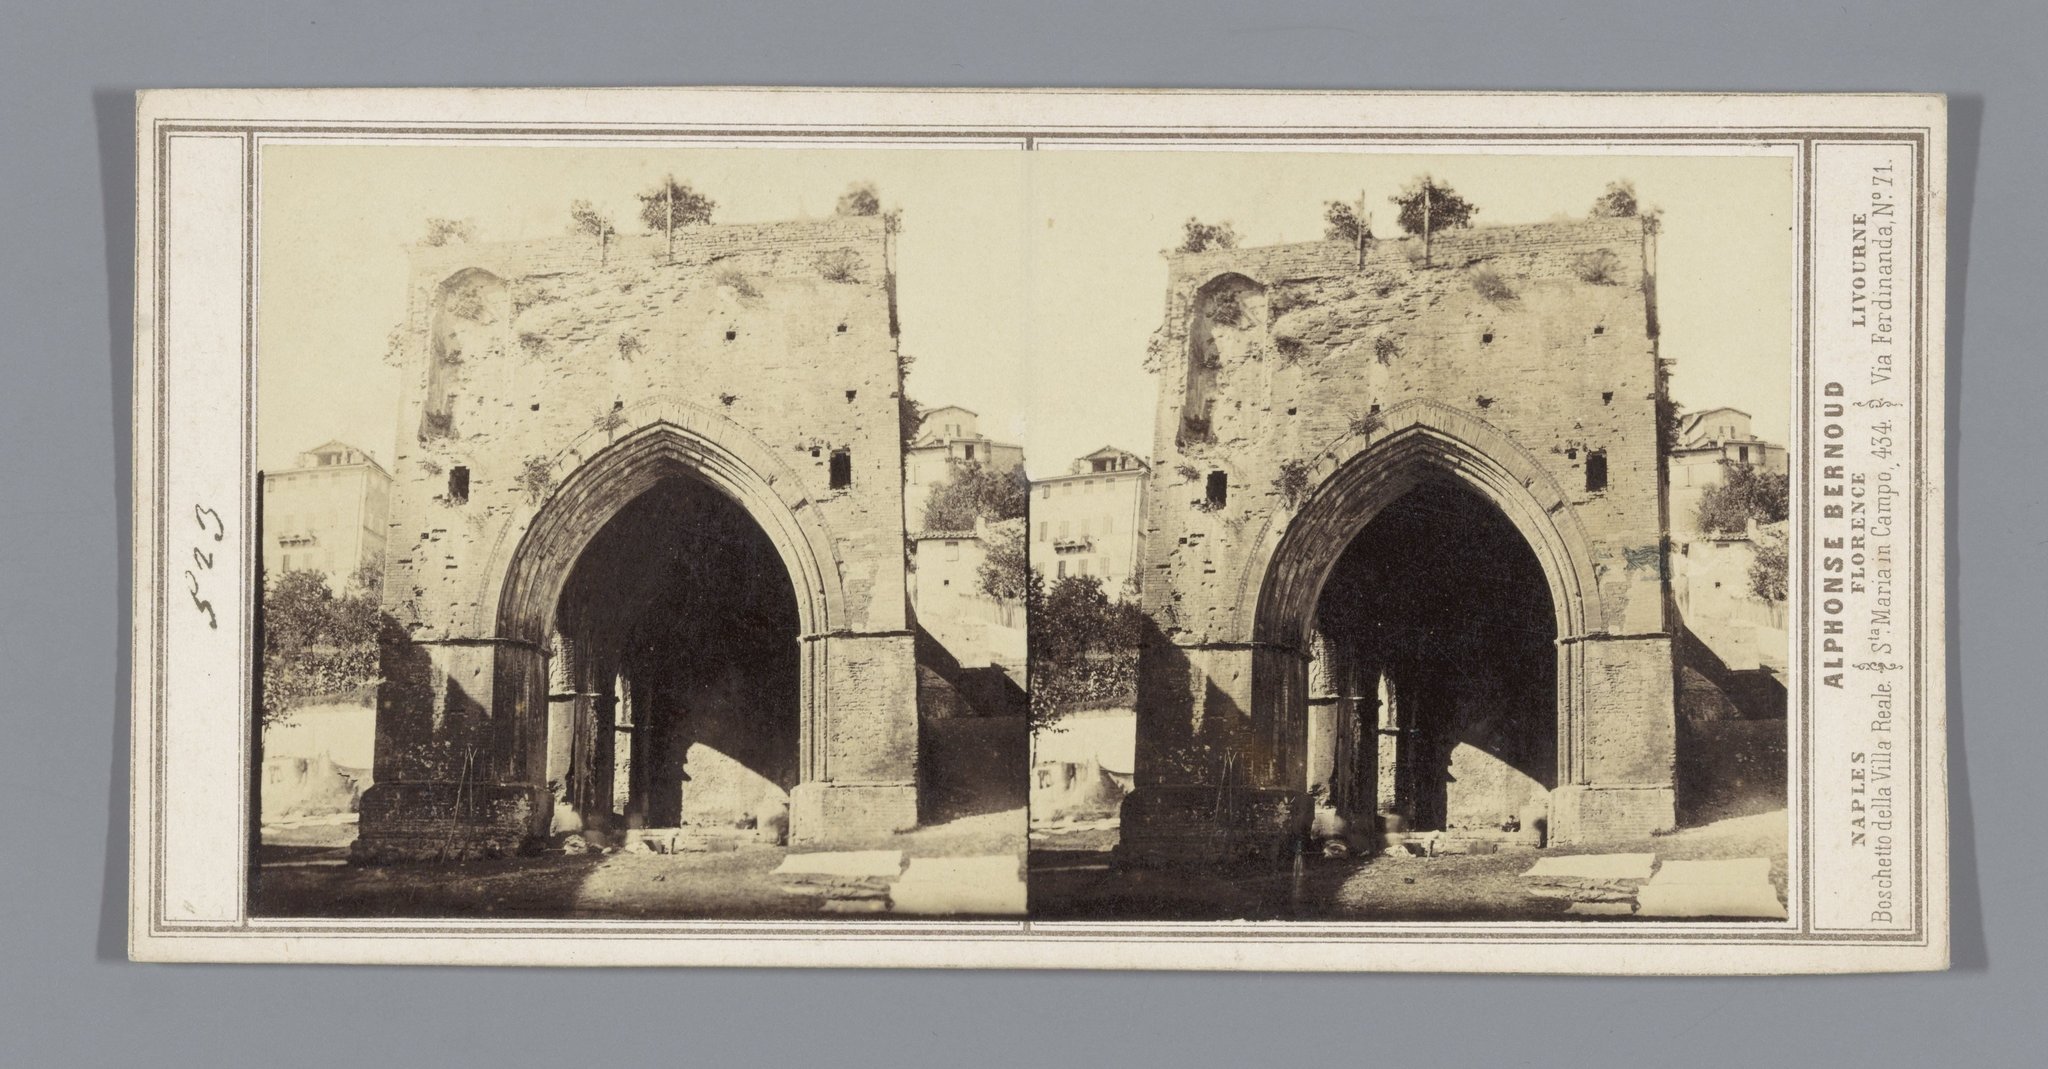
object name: stereograph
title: Gevel van de Fonte Nuova te Siena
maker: alphonse bernoud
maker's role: fotograaf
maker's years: 1820-1889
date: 1850-1880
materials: cardboard, photographic support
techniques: albumen print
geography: siena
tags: water tower, façade (of house or building)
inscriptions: name: ‘ALPHONSE BERNOUD NAPLES Boschetto della Villa Reale FLORENCE Place S. Maria in Campo 434. LIVOURNE Via Ferdinanda, No 71.’, number: ‘523’, inscription: ‘Fonte nuova à Siena’